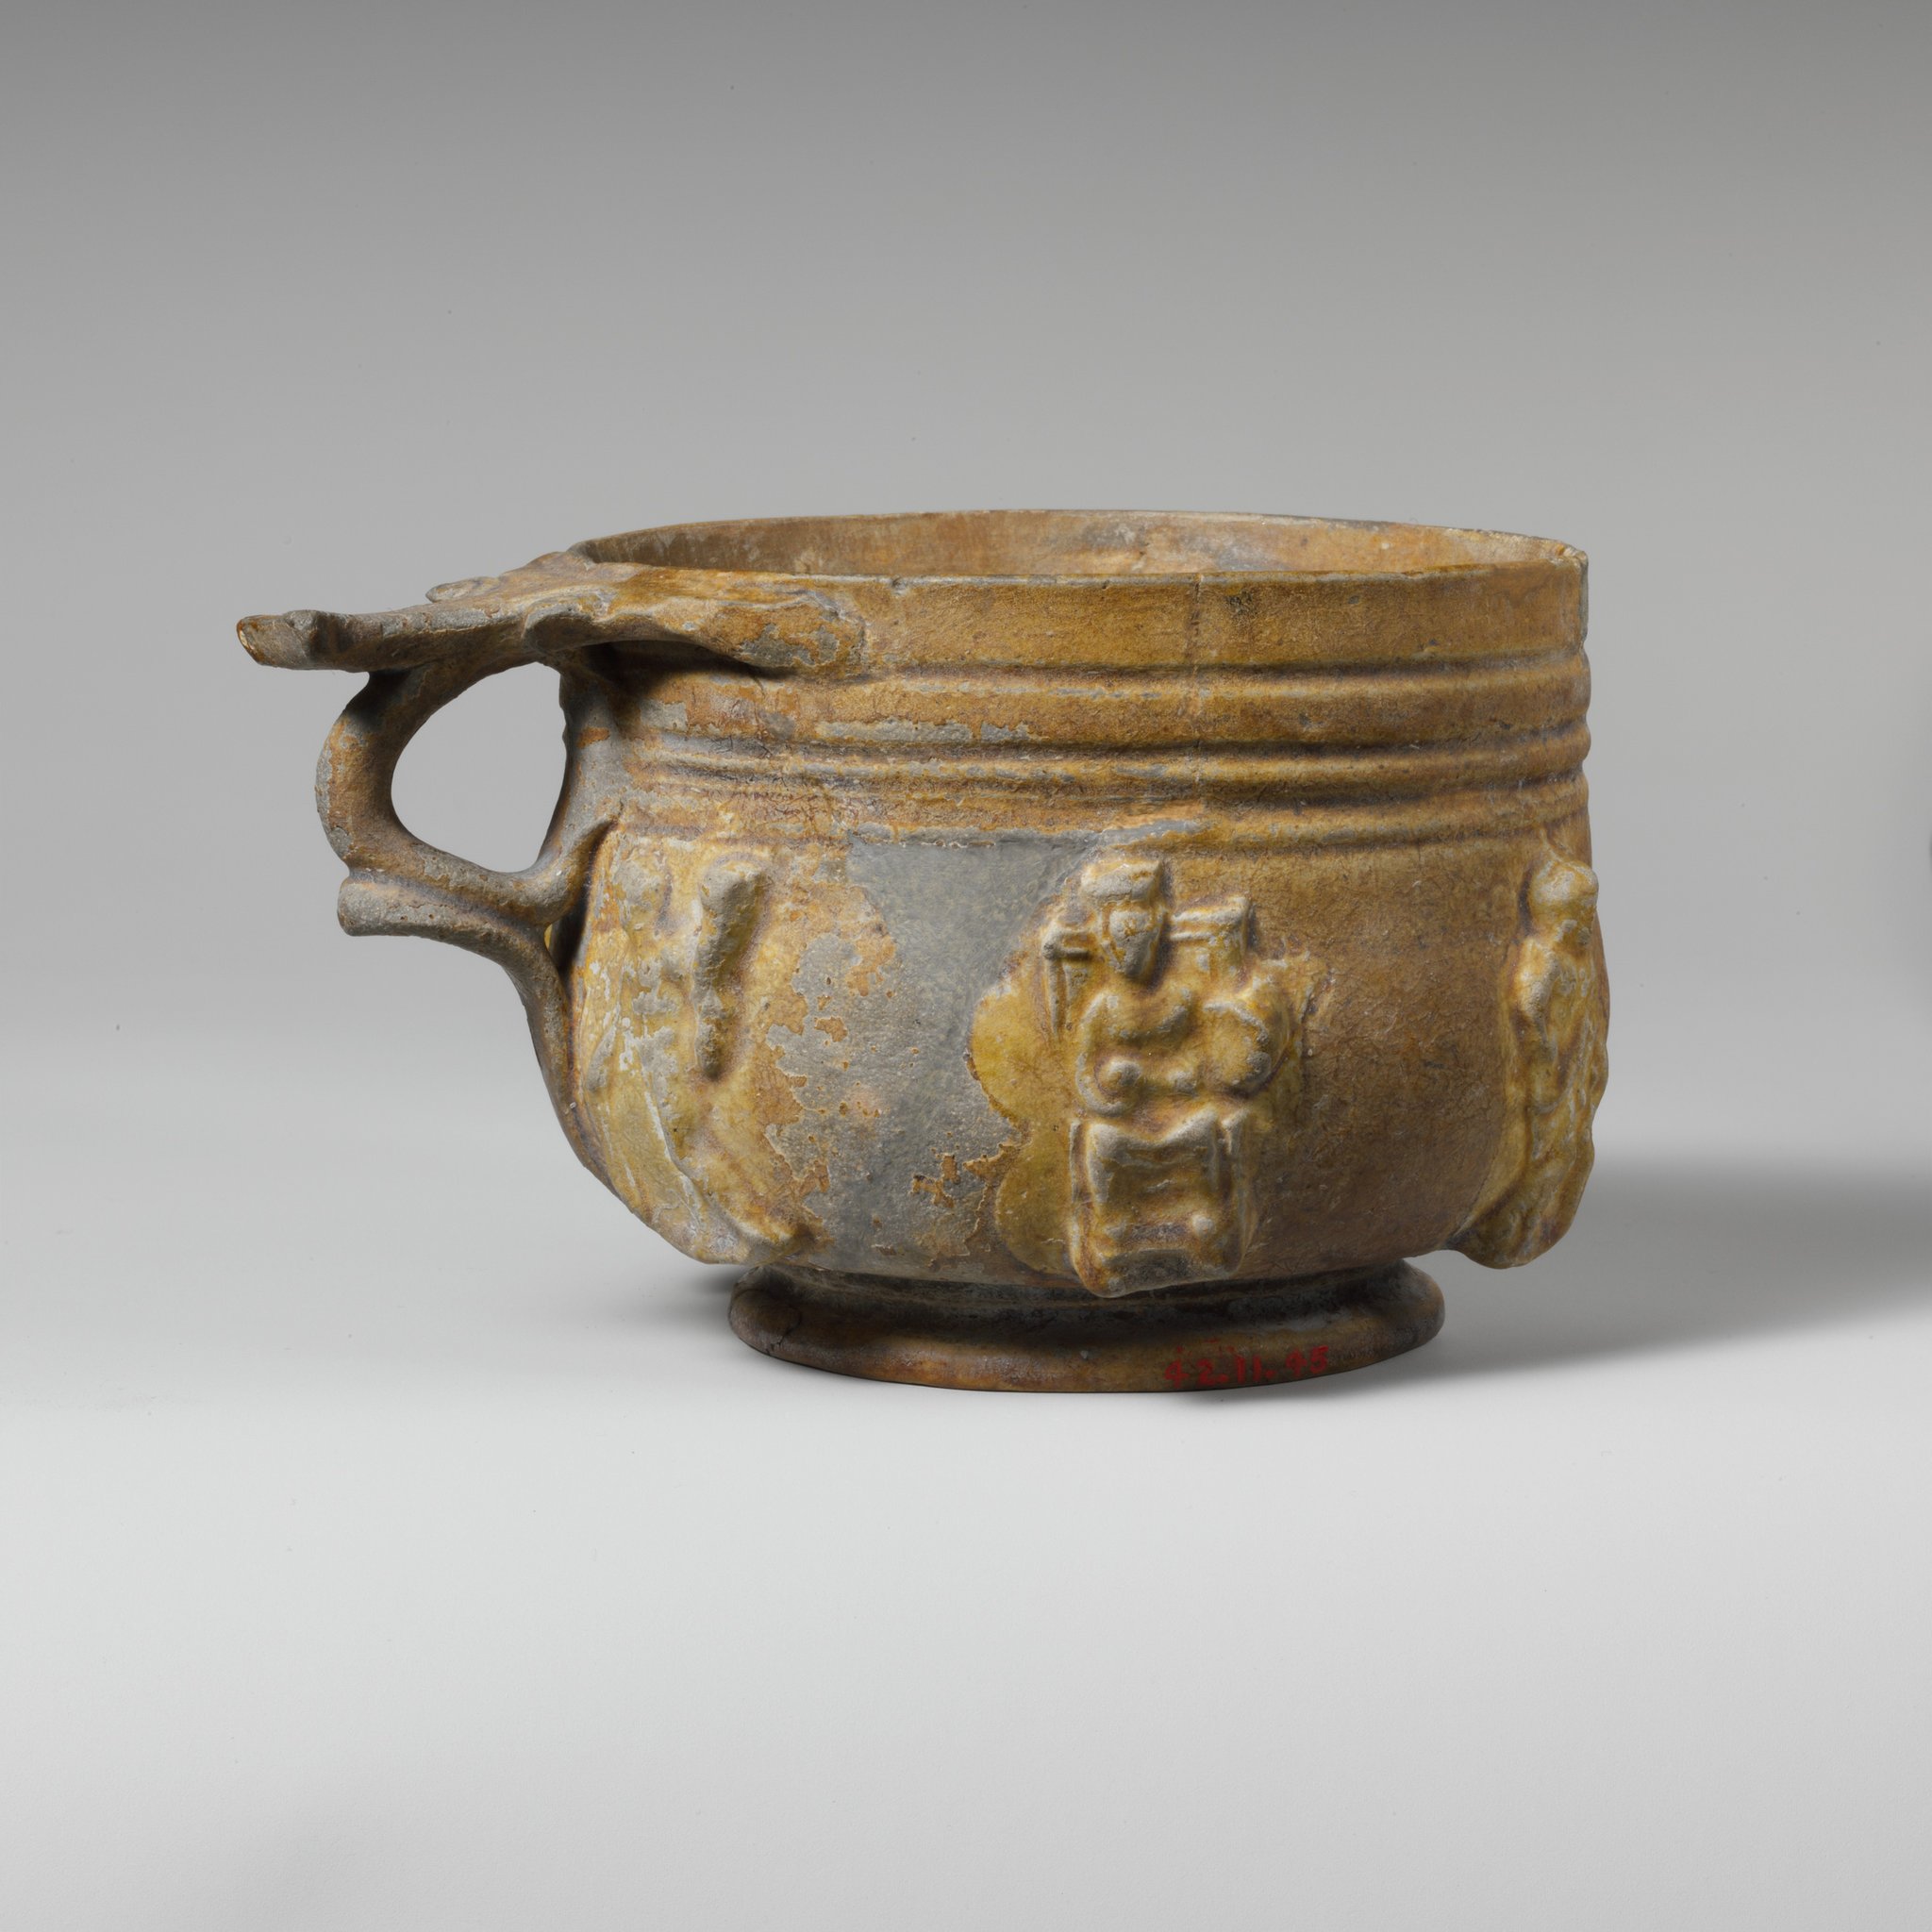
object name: skyphos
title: Terracotta scyphus (drinking cup)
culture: roman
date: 34 BCE-33 CE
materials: terracotta